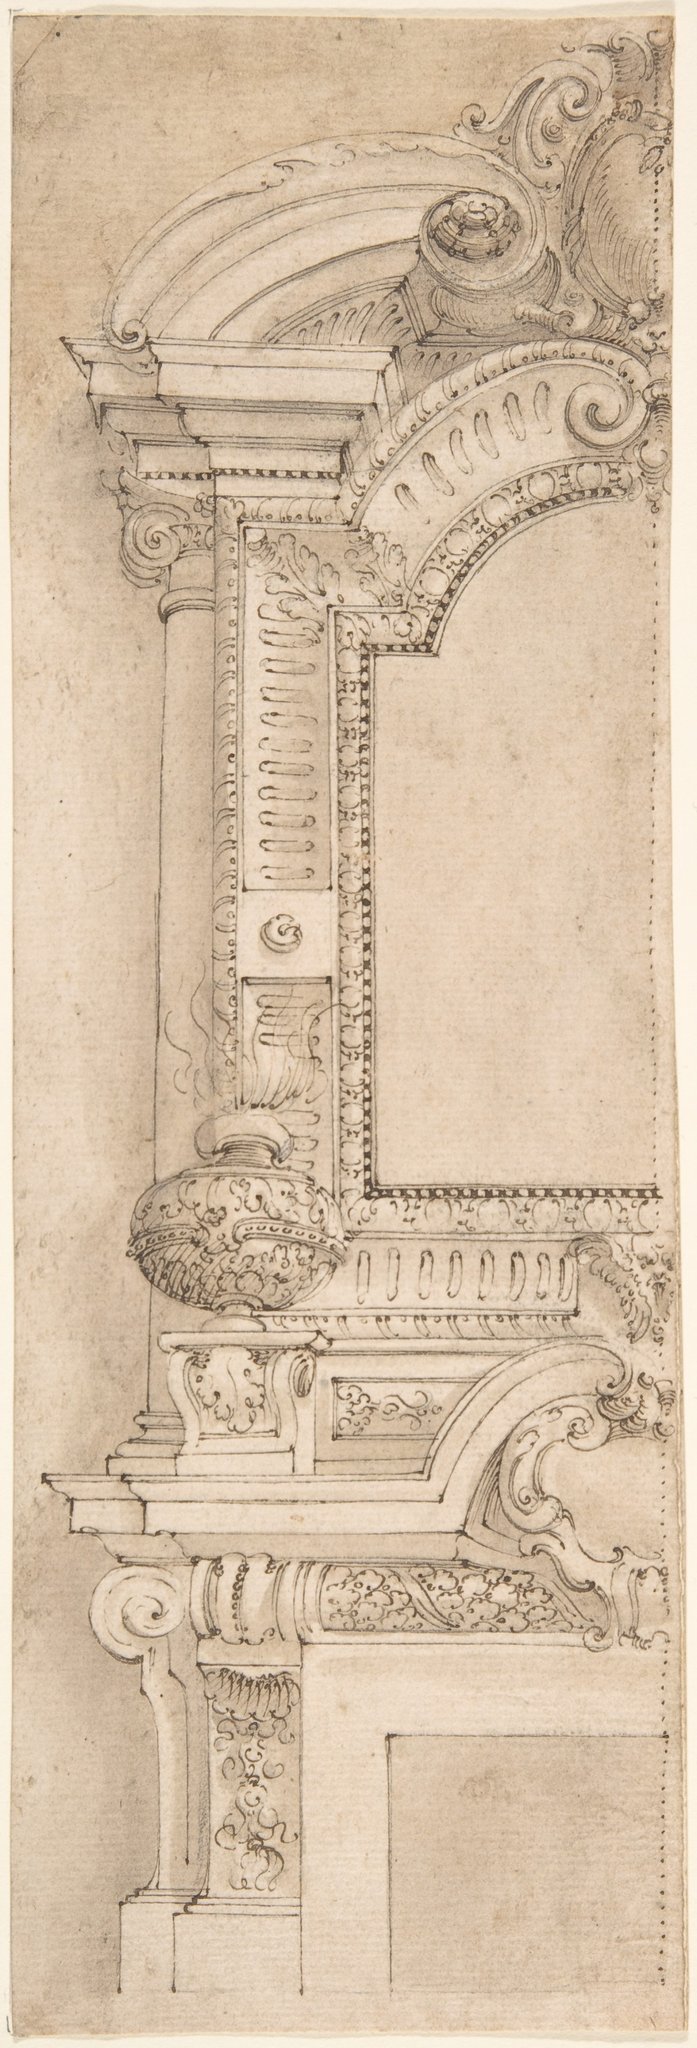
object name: drawing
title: Design for the left half of a chimneypiece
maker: anonymous, italian, 17th century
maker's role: artist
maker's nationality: italian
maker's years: 1600-1700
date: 1601-1700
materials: ink, drawing material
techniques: brush, pen, wash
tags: fireplaces